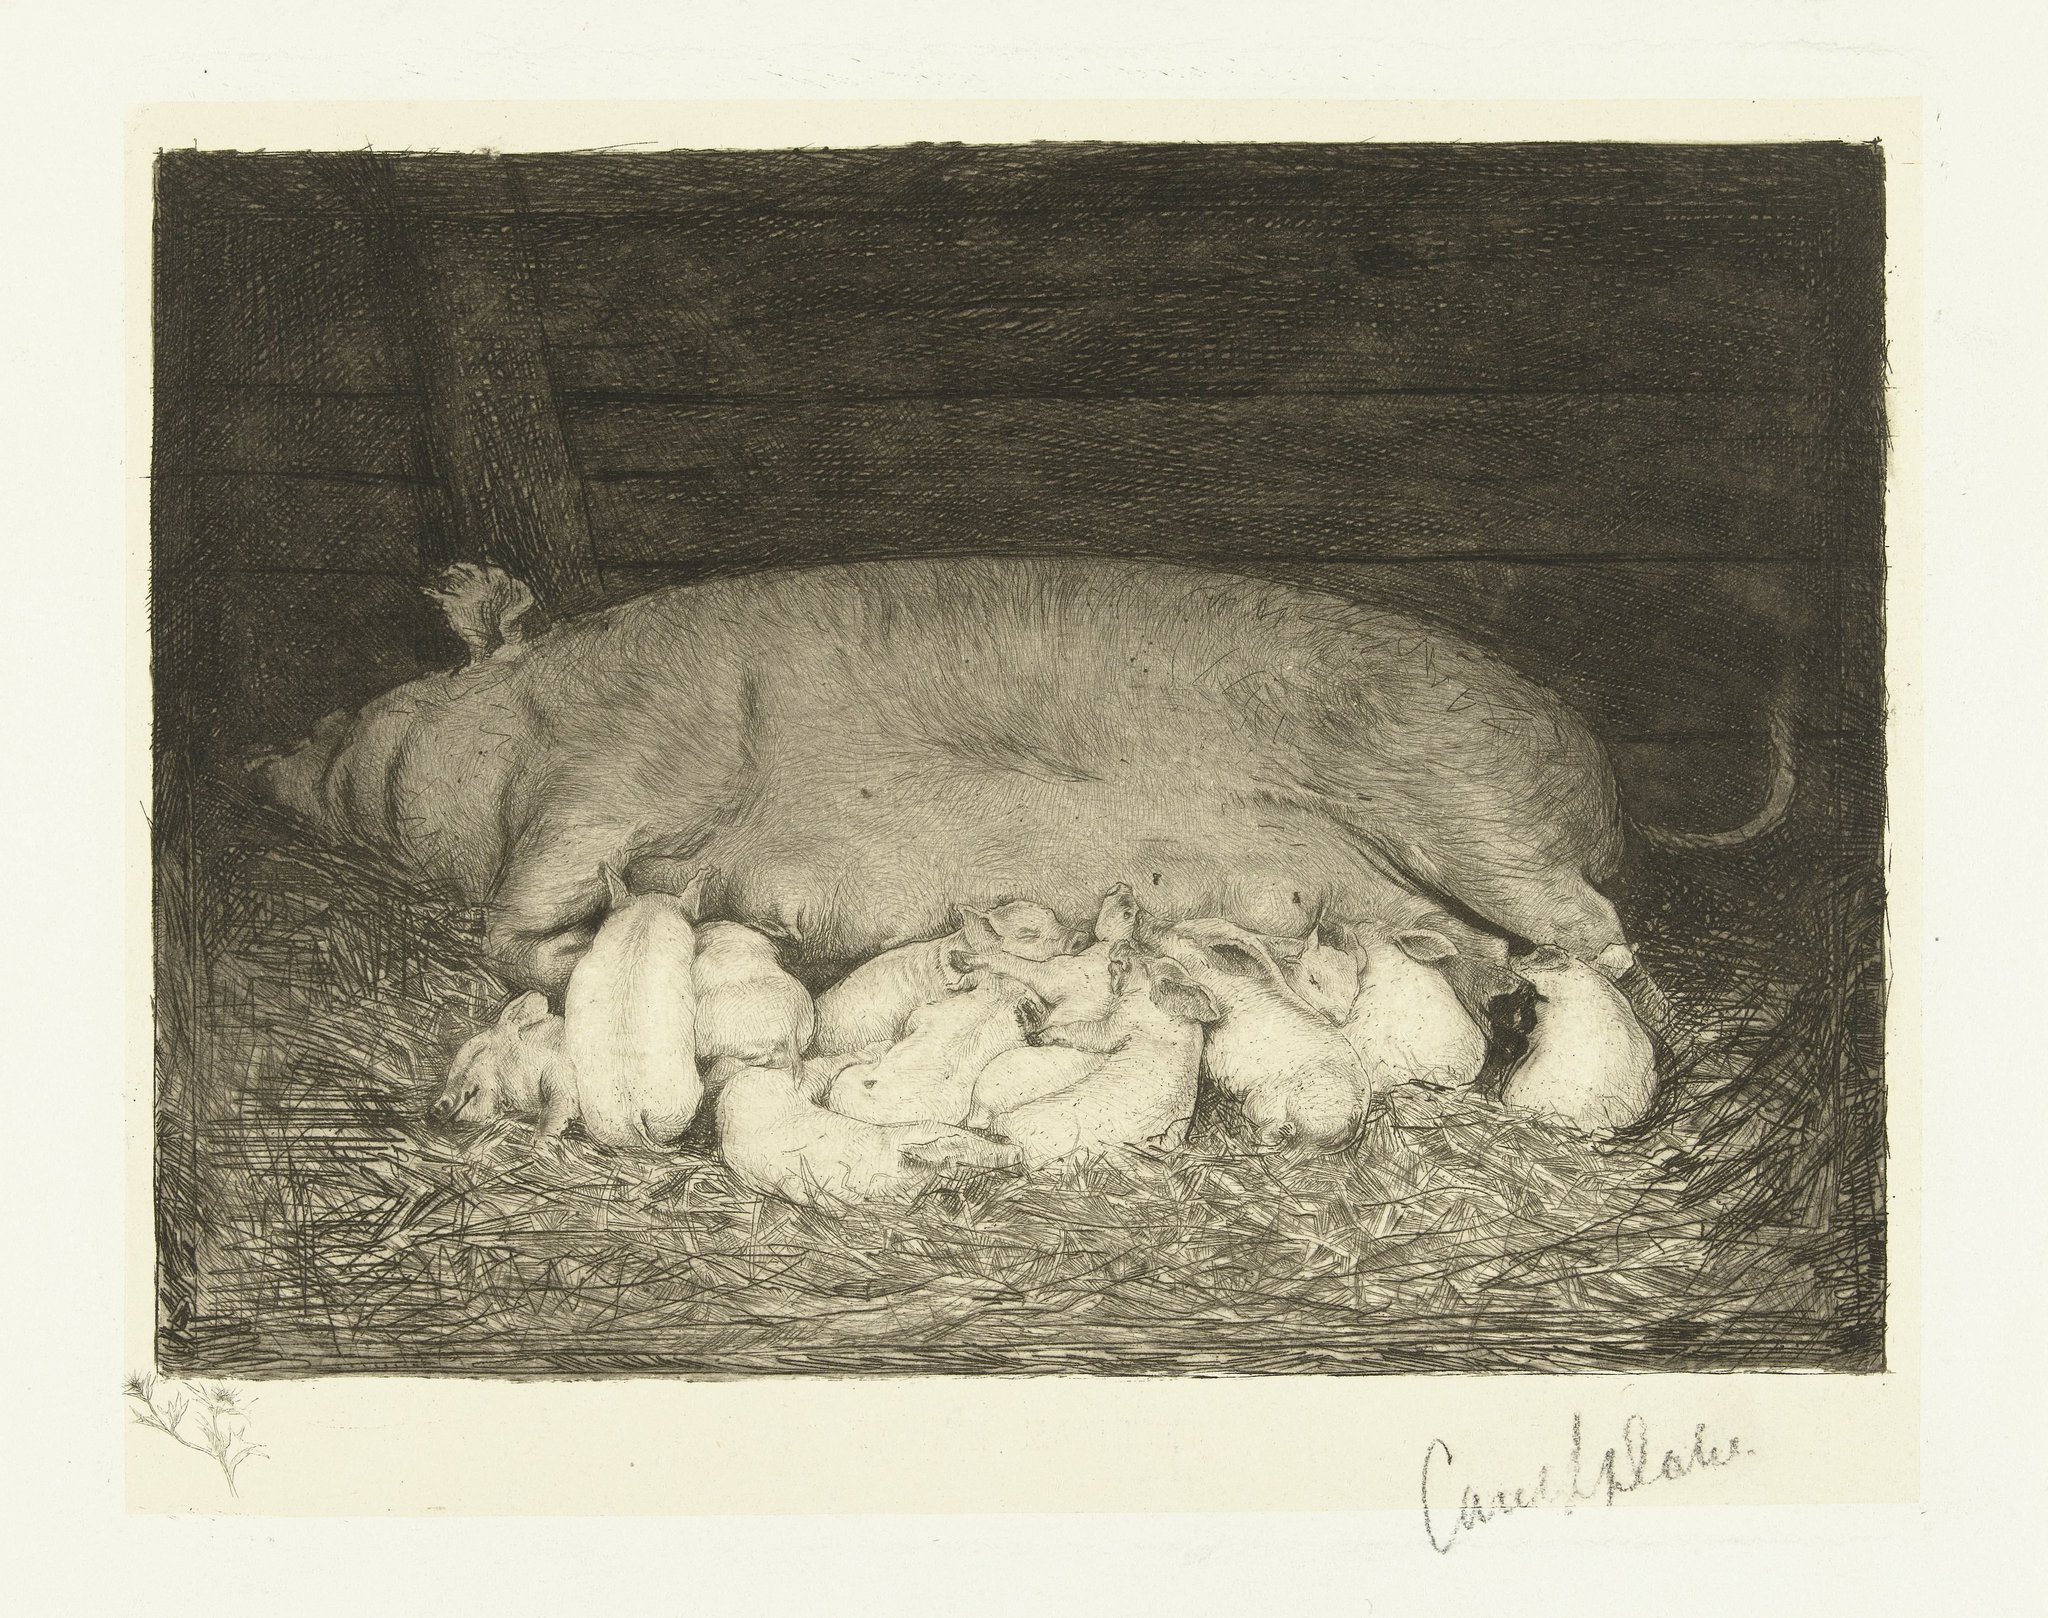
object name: print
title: Zeug met biggen liggend in stal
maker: carel lodewijk dake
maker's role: draughtsman, painter, print maker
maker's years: 1857-1918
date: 1867-1886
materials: paper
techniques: drypoint, etching, intaglio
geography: amsterdam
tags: sow, piglet, suckling pig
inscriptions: collector's mark: Lugt 2228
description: Andere staat gebruikt voor: C. Vosmaer (red.), De distel, etsen van Nederlandsche schilders, 3 delen, Amsterdam 1886, deel I